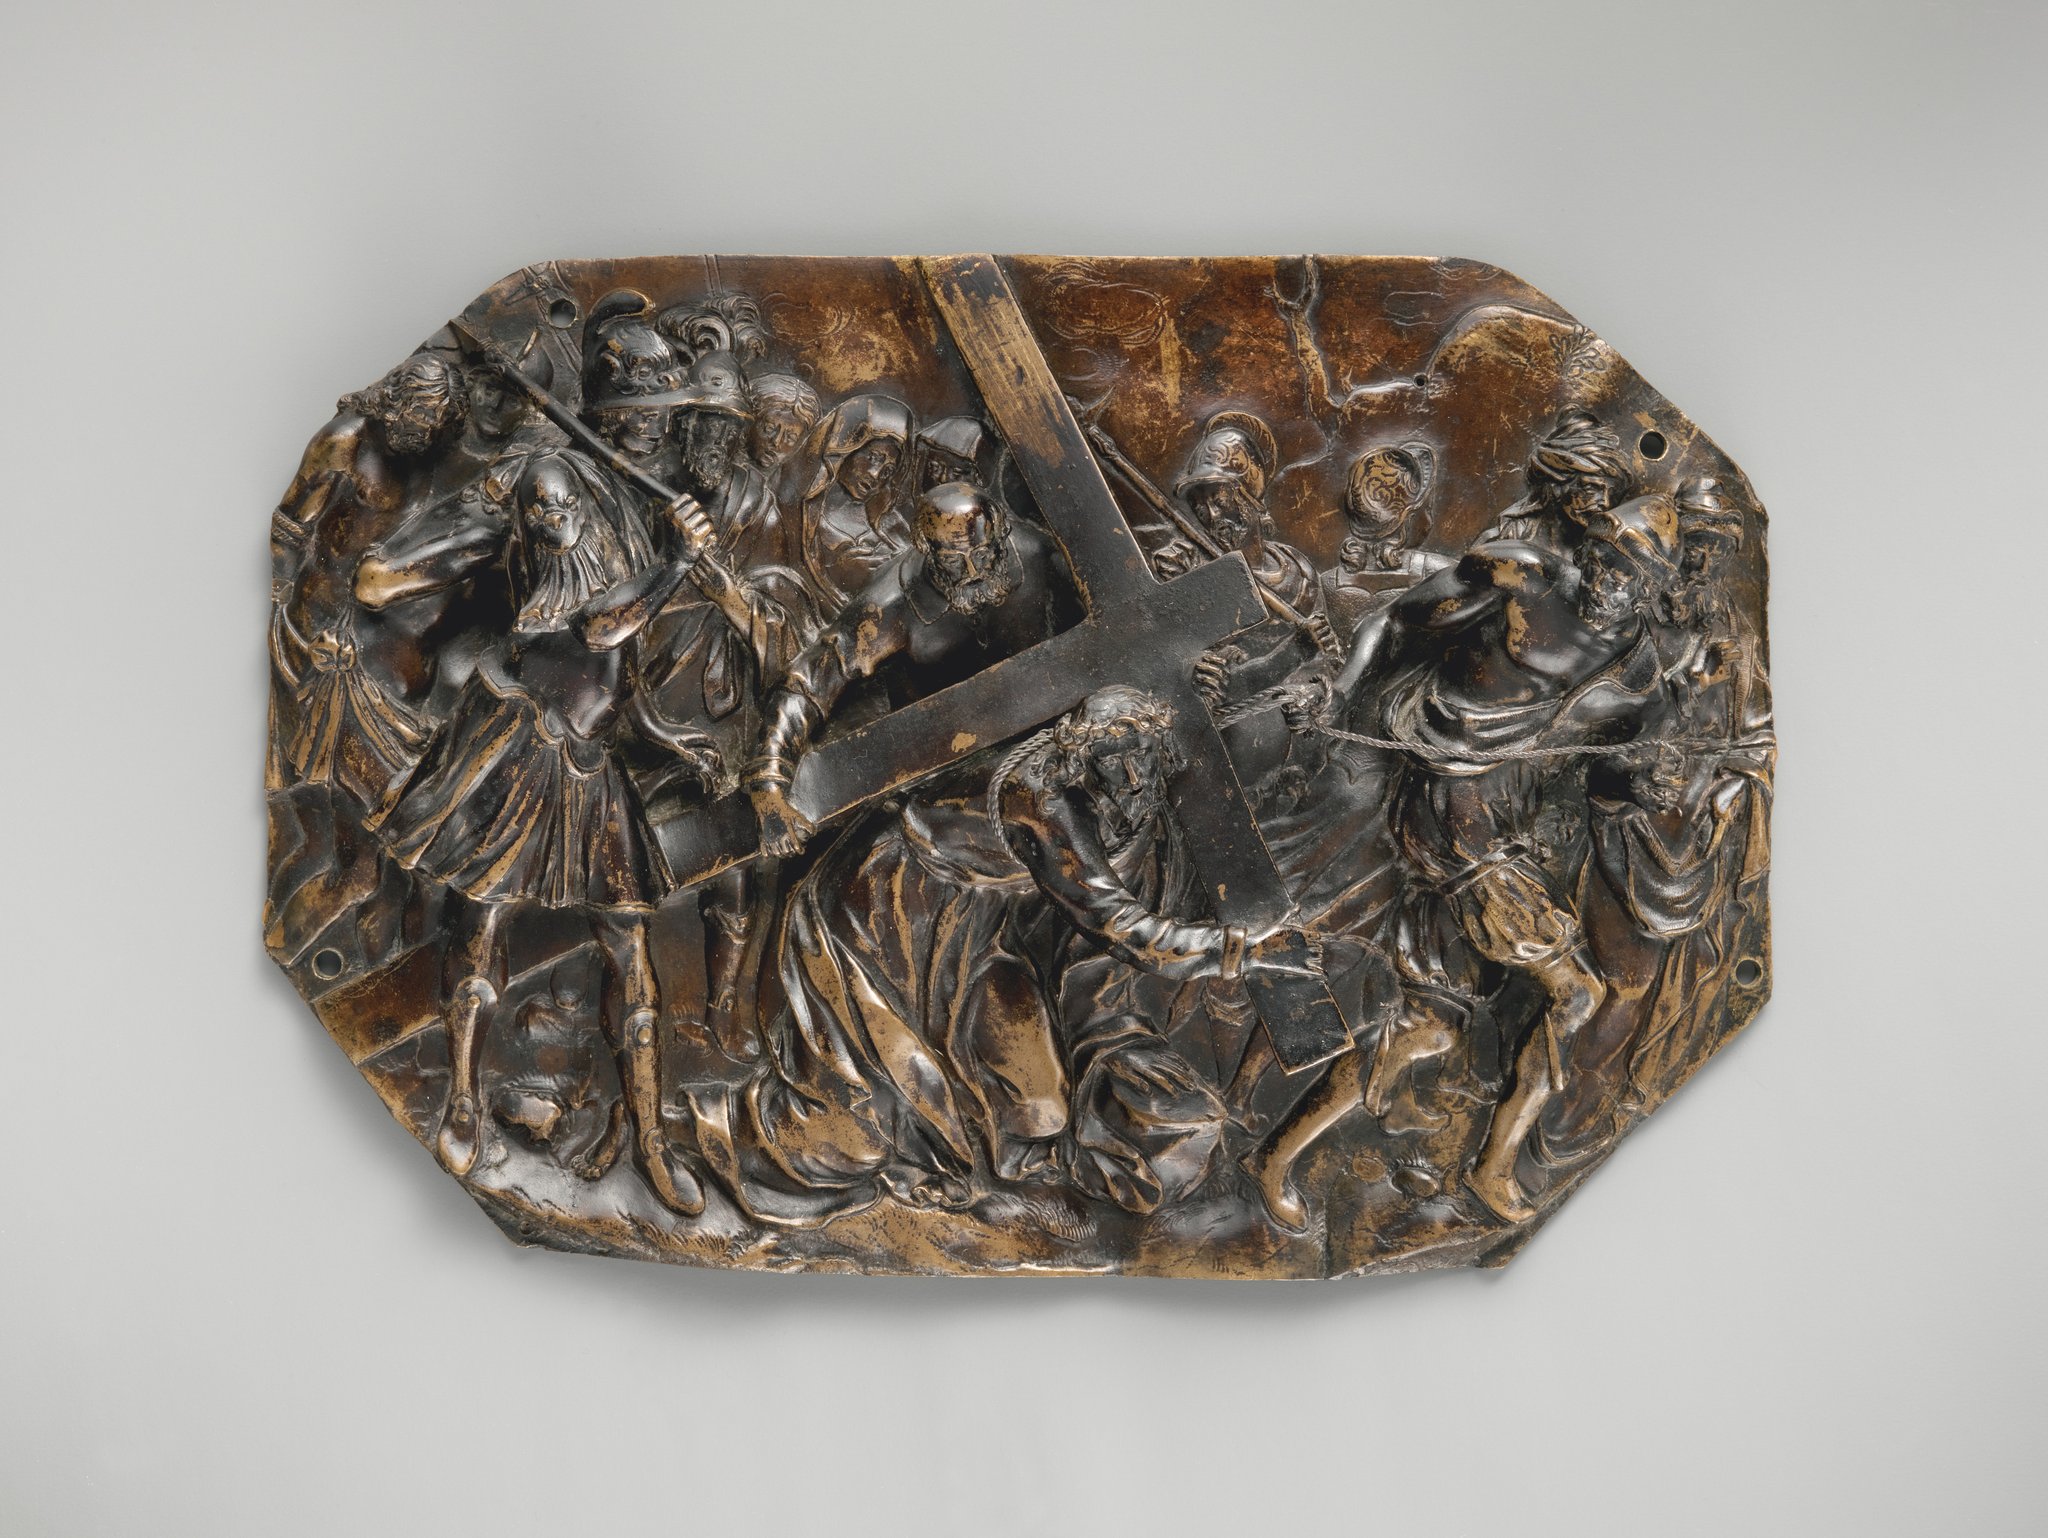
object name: relief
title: Christ bearing the cross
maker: ferdinando tacca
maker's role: artist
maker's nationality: italian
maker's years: 1619-1686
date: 1634-1666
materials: bronze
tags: cross,jesus,crowd